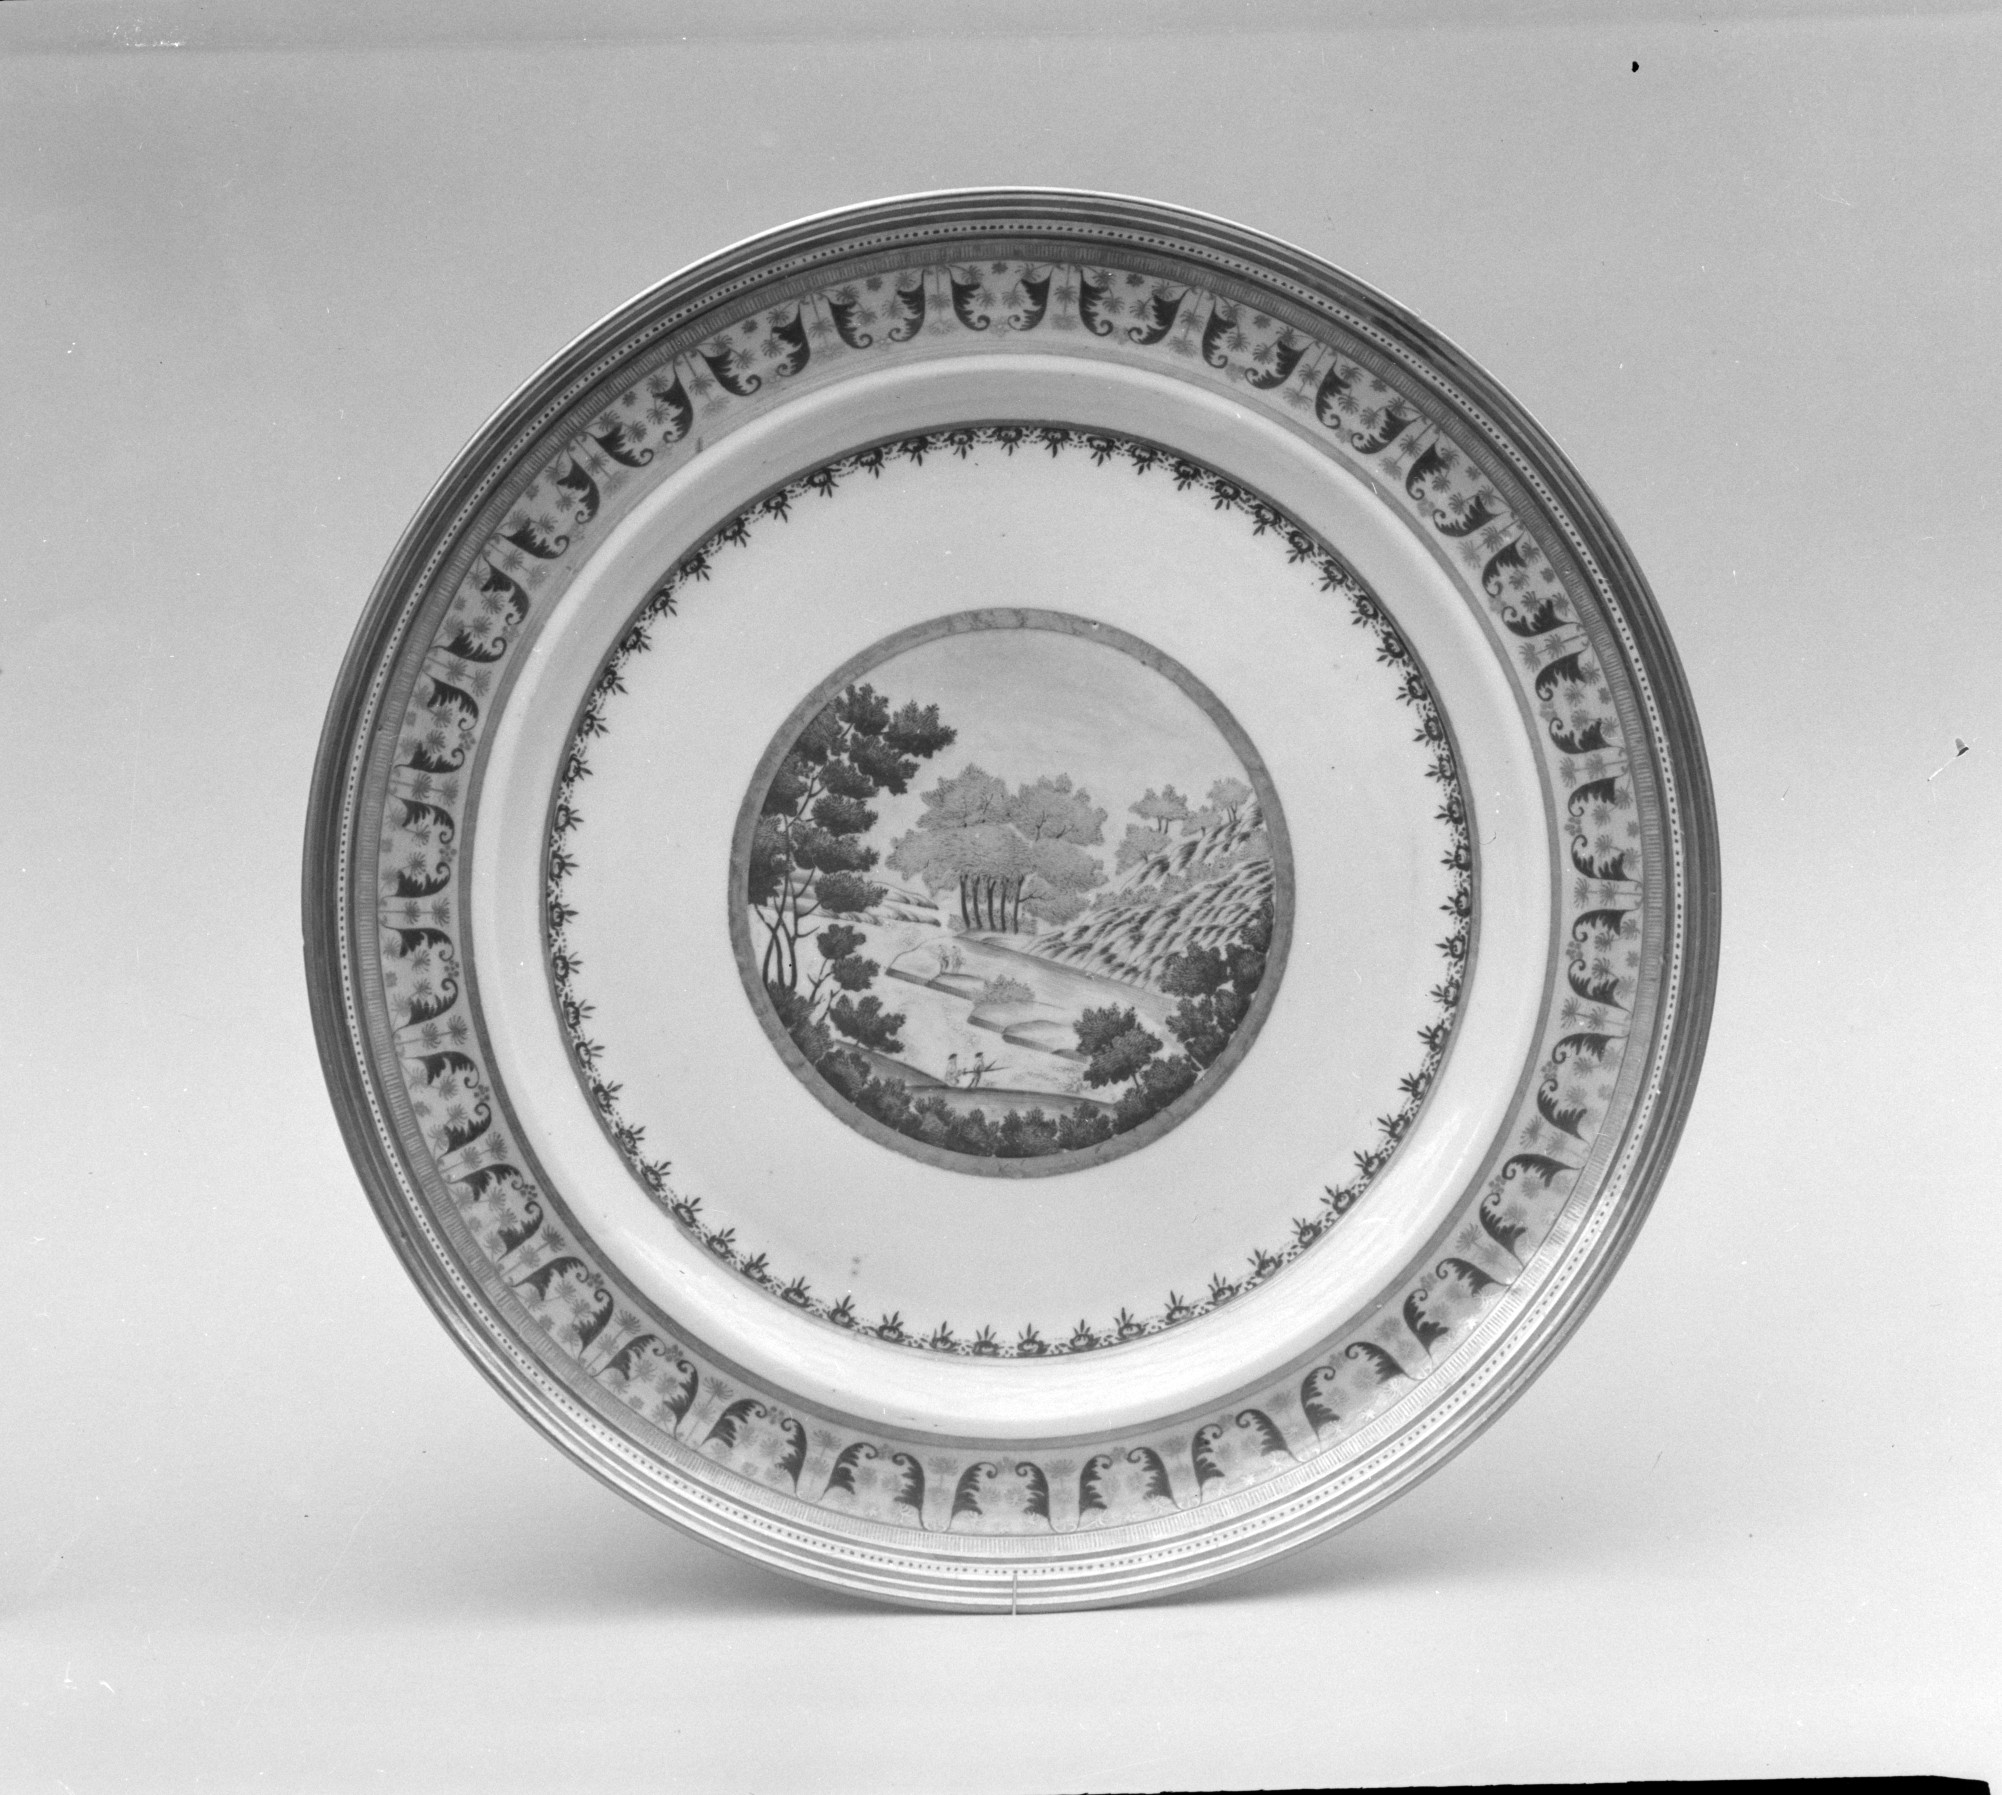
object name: plate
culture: chinese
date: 1800-1830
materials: porcelain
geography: china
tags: landscapes